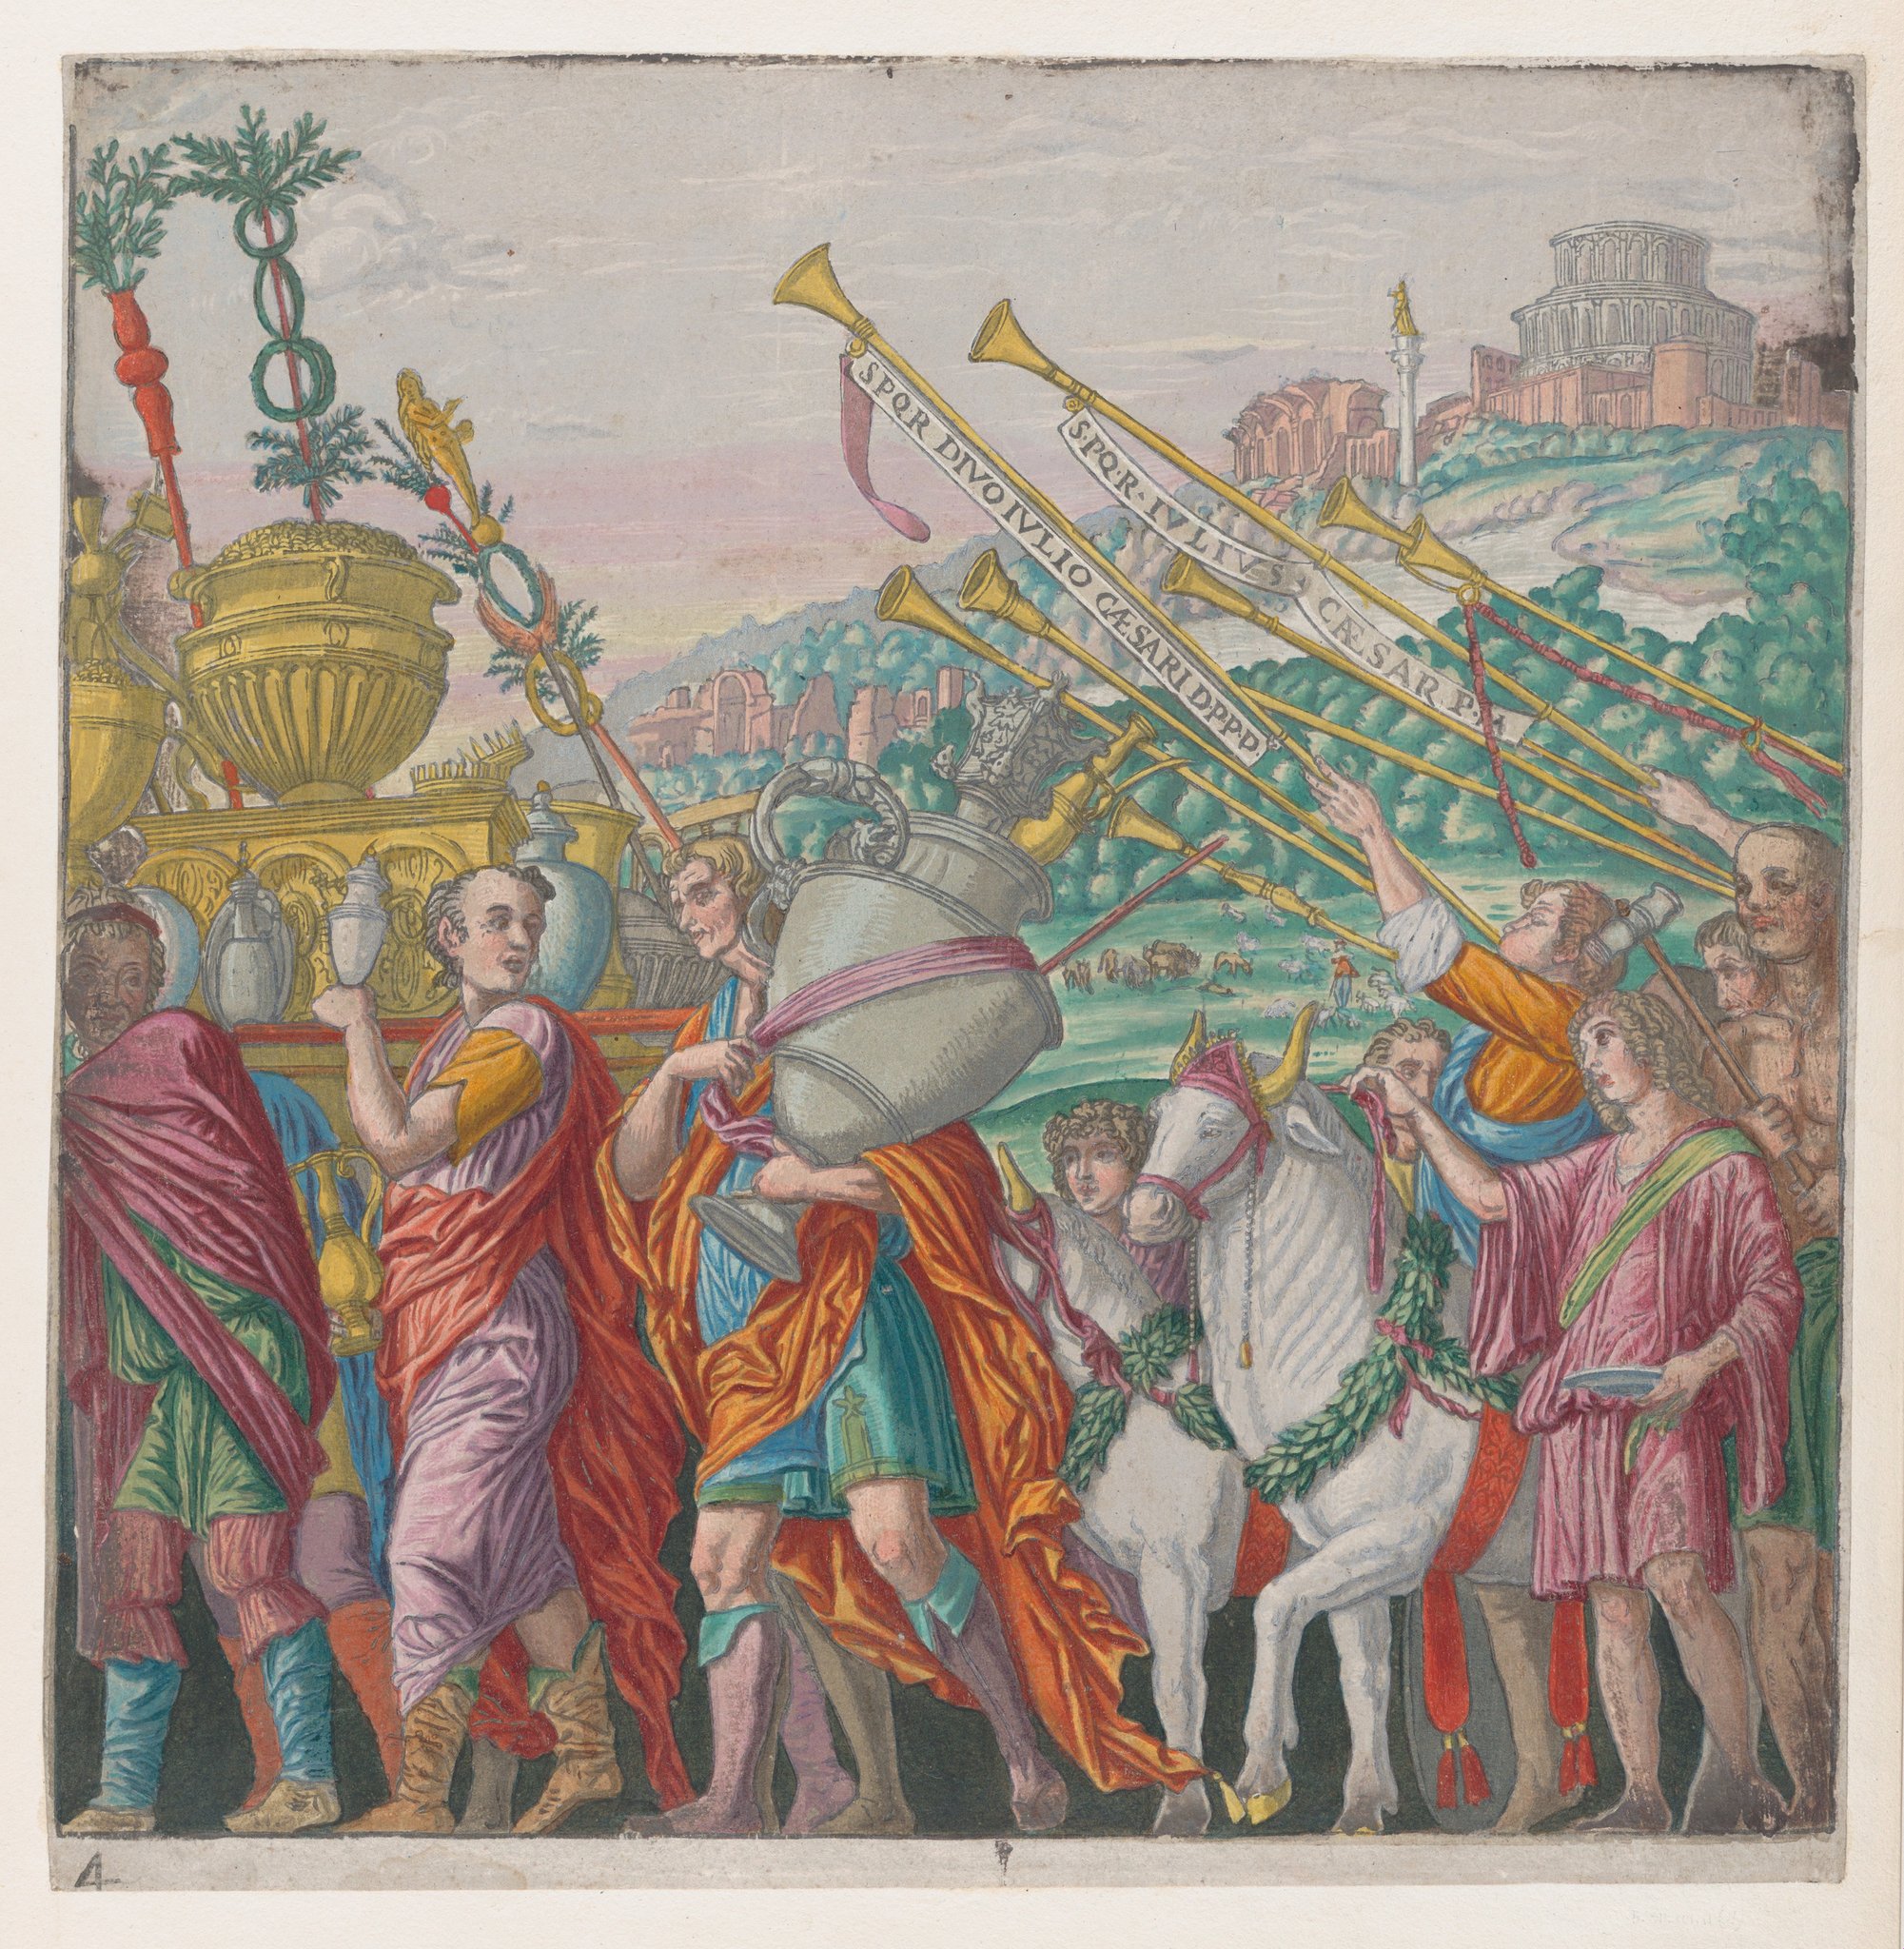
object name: print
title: Sheet 4: Men carrying trophies at left, trumpeters at right, from "The Triumph of Julius Caesar"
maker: andrea andreani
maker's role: artist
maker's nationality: italian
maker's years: 1558-1629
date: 1599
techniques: hand coloring, woodcut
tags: musical instruments,men,cows,trophies